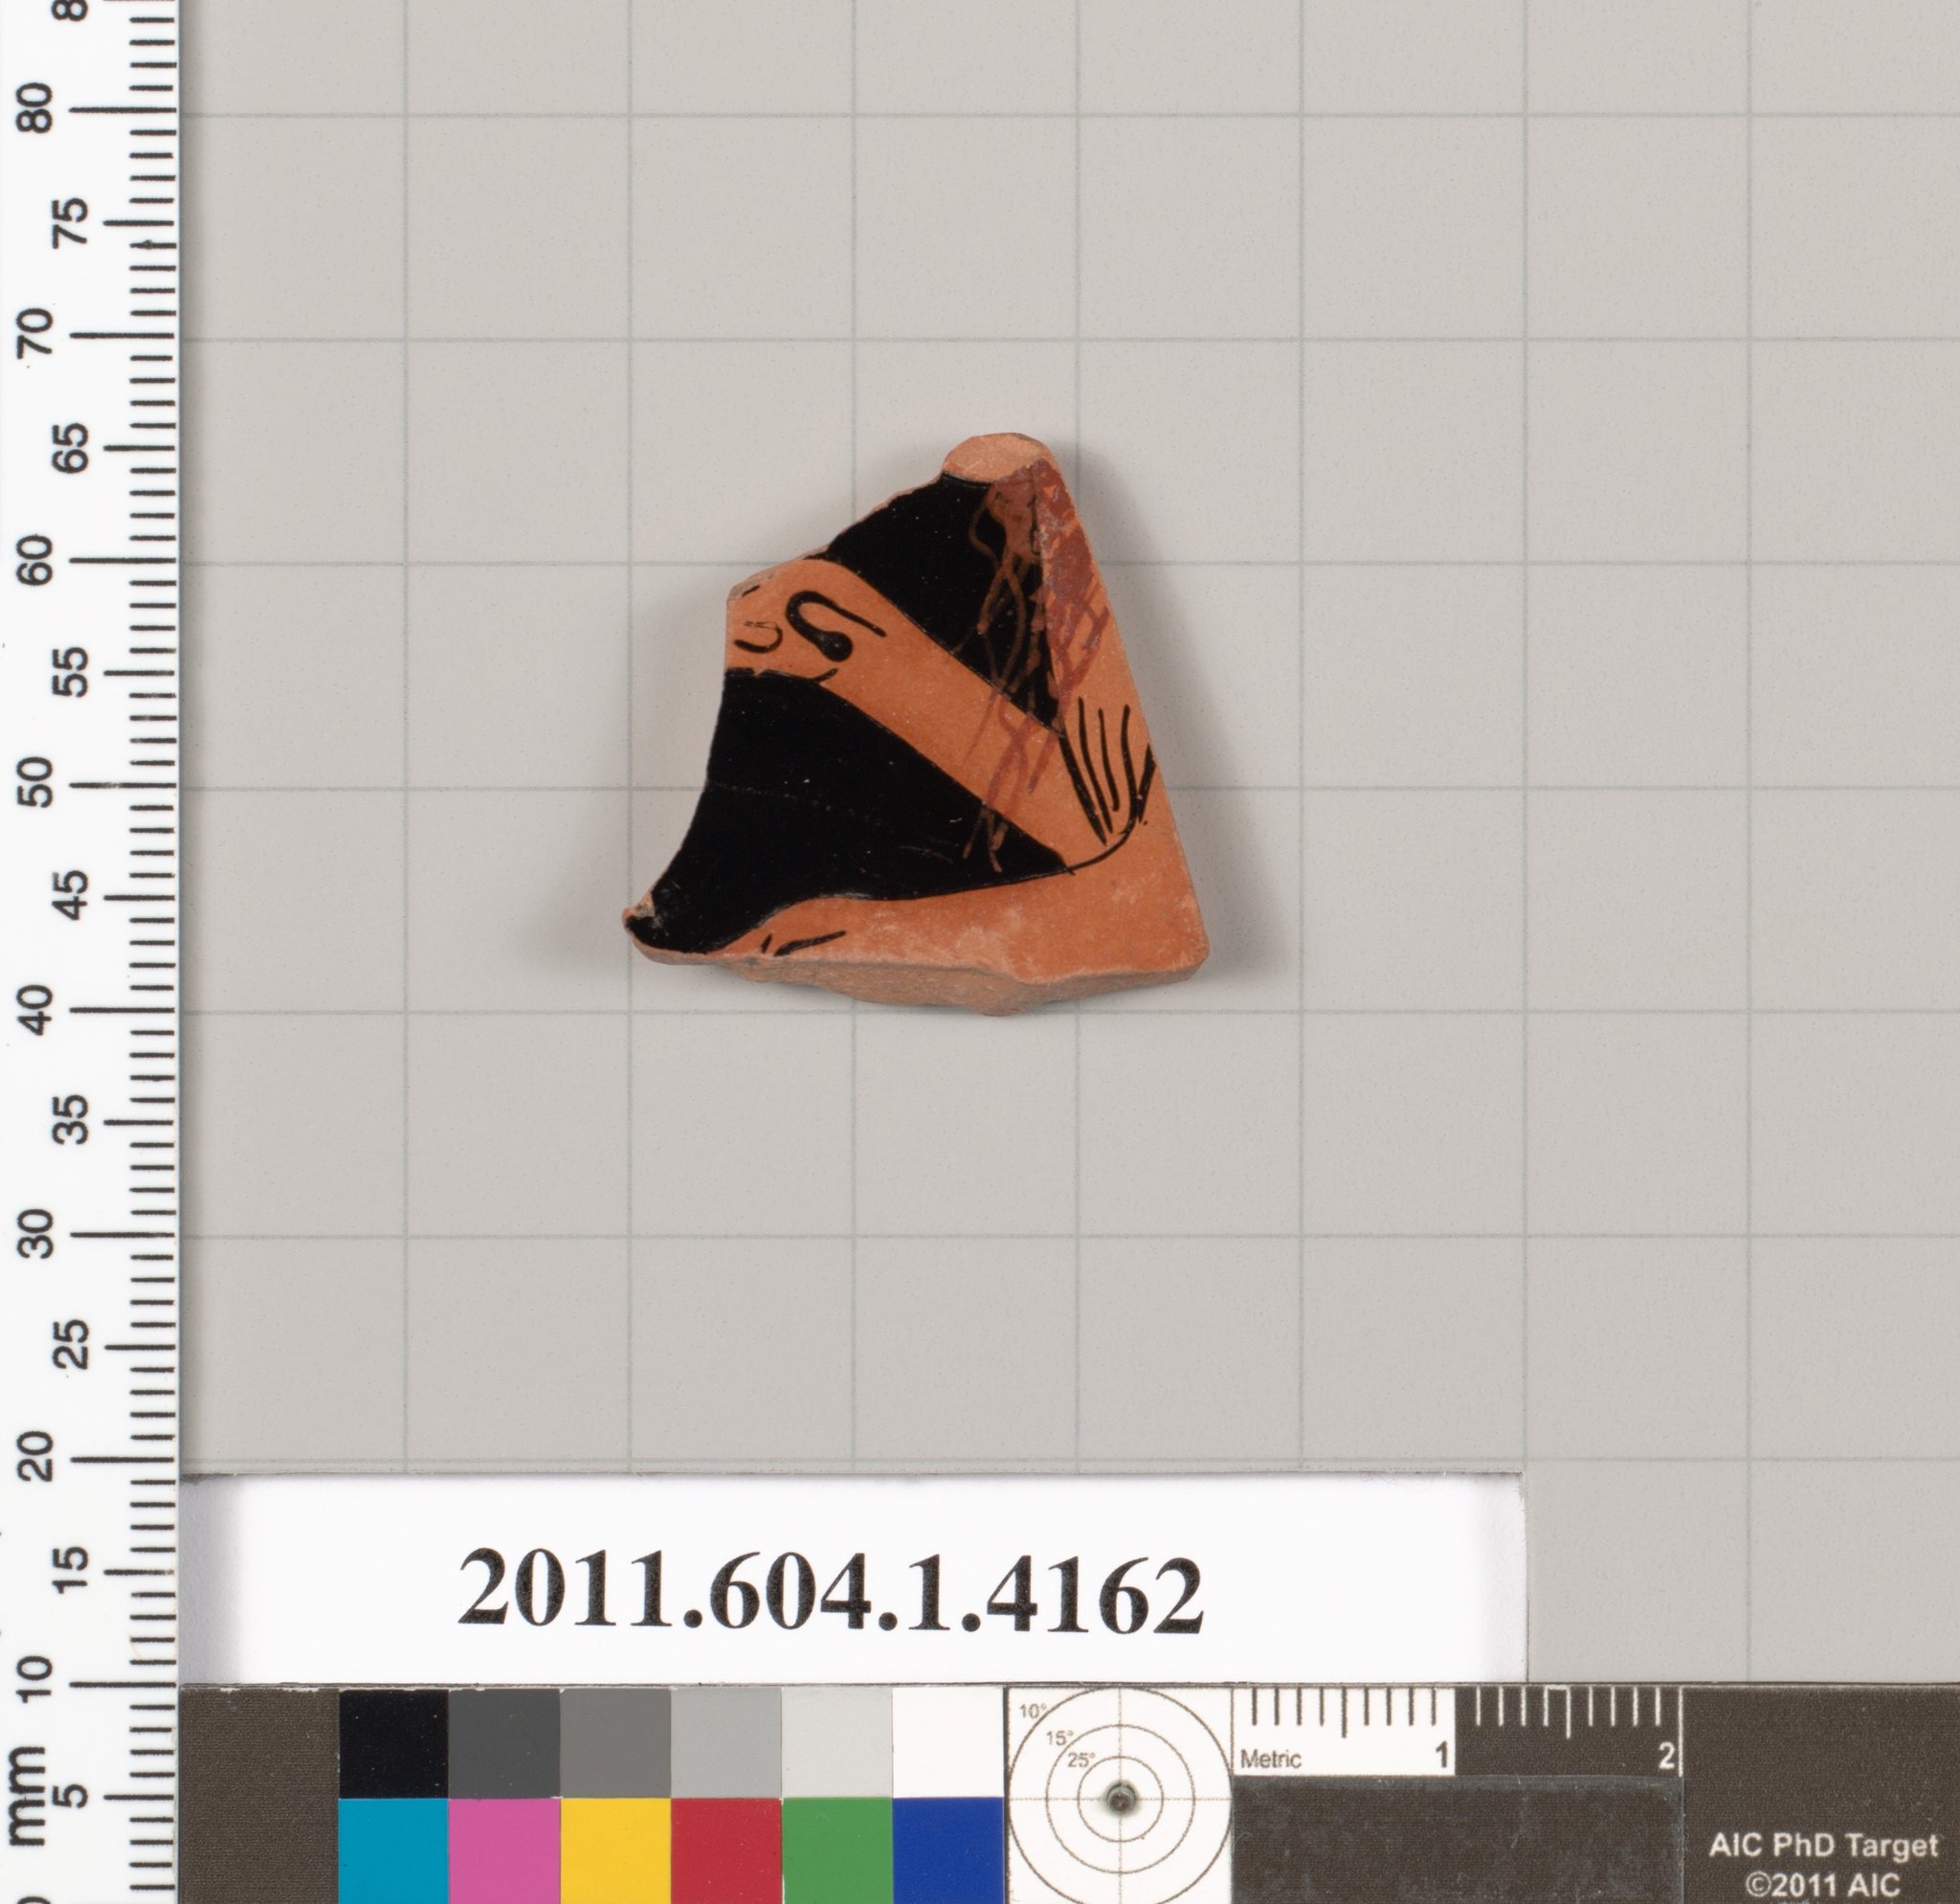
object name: kylix fragment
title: Terracotta fragment of a kylix (drinking cup)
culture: greek, attic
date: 490-470 BCE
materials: terracotta